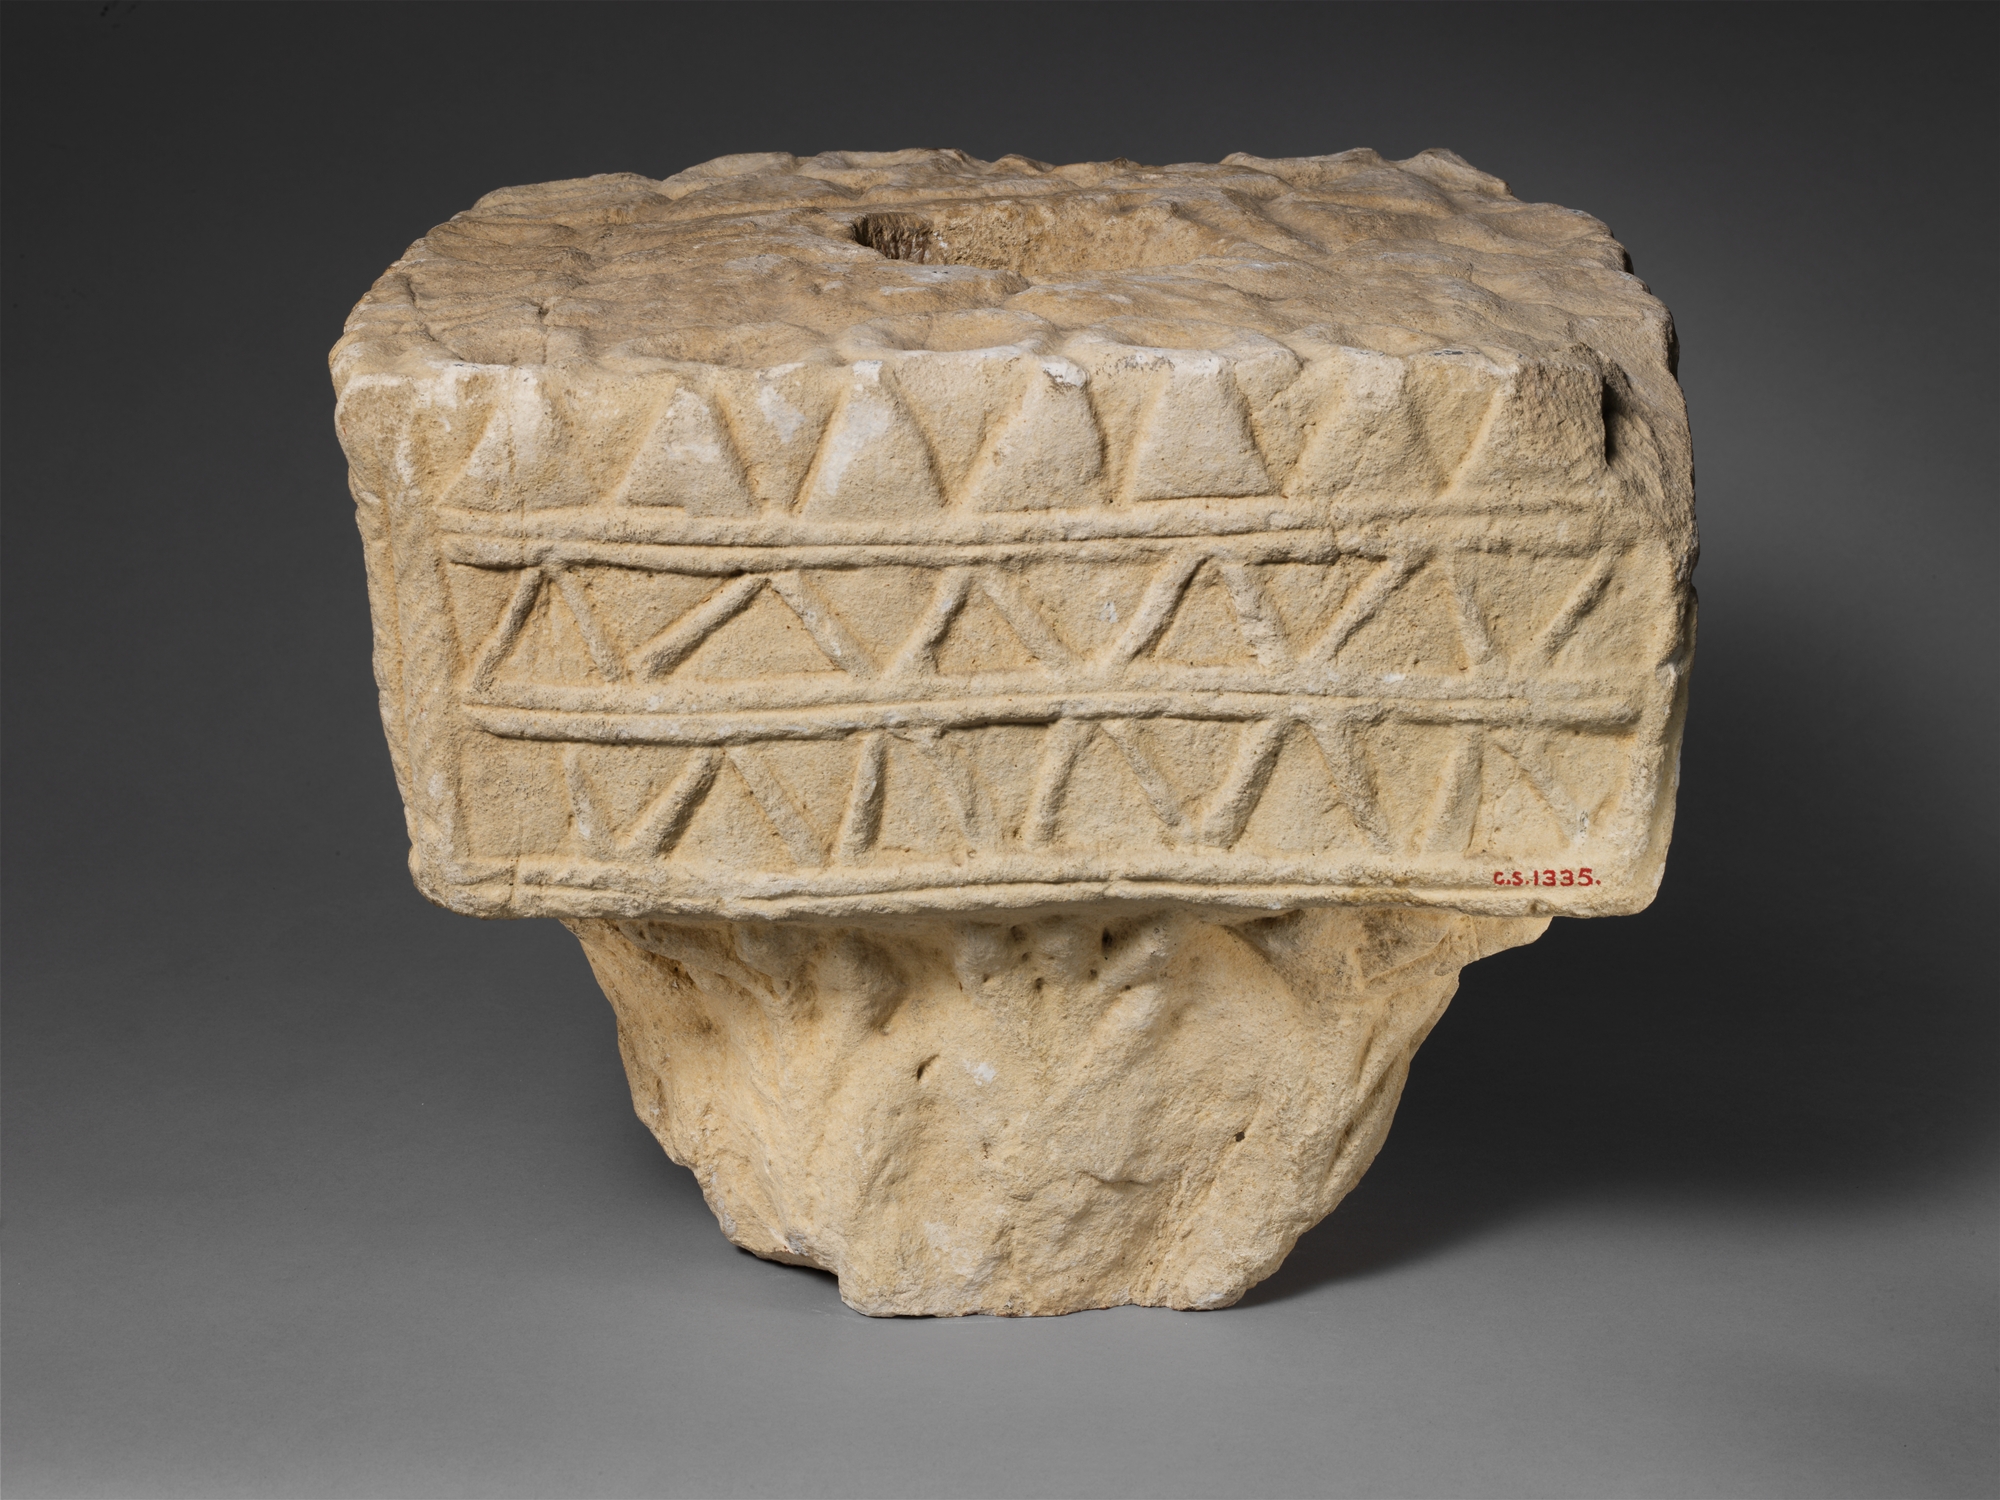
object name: capital, corinthian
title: Limestone votive square capital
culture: cypriot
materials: limestone